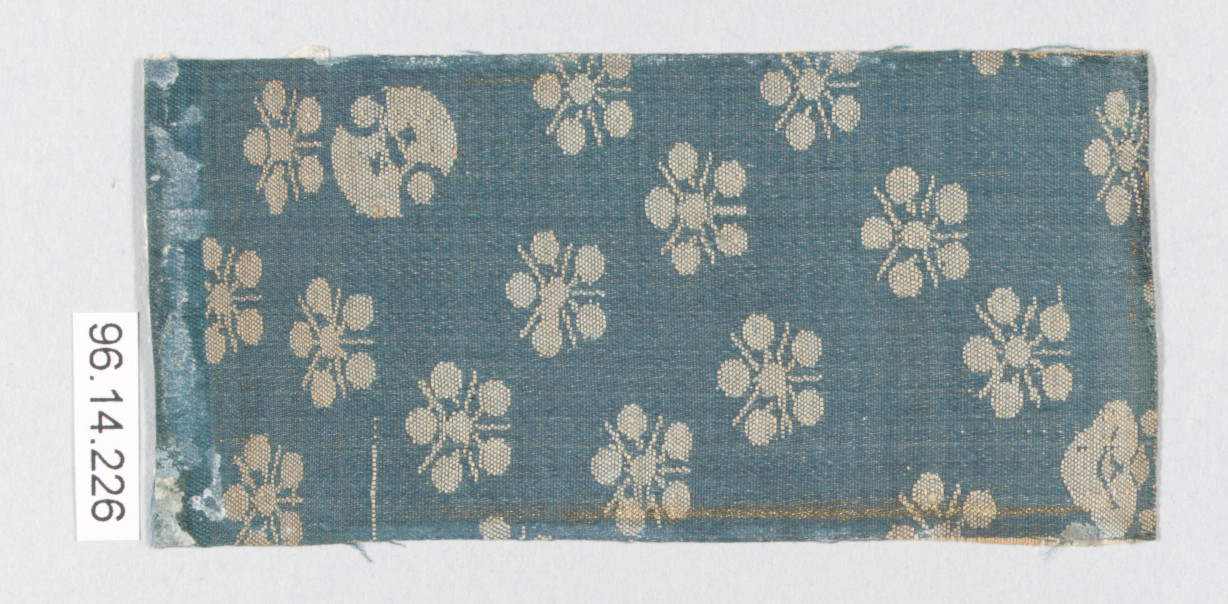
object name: piece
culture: japanese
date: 1701-1900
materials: silk